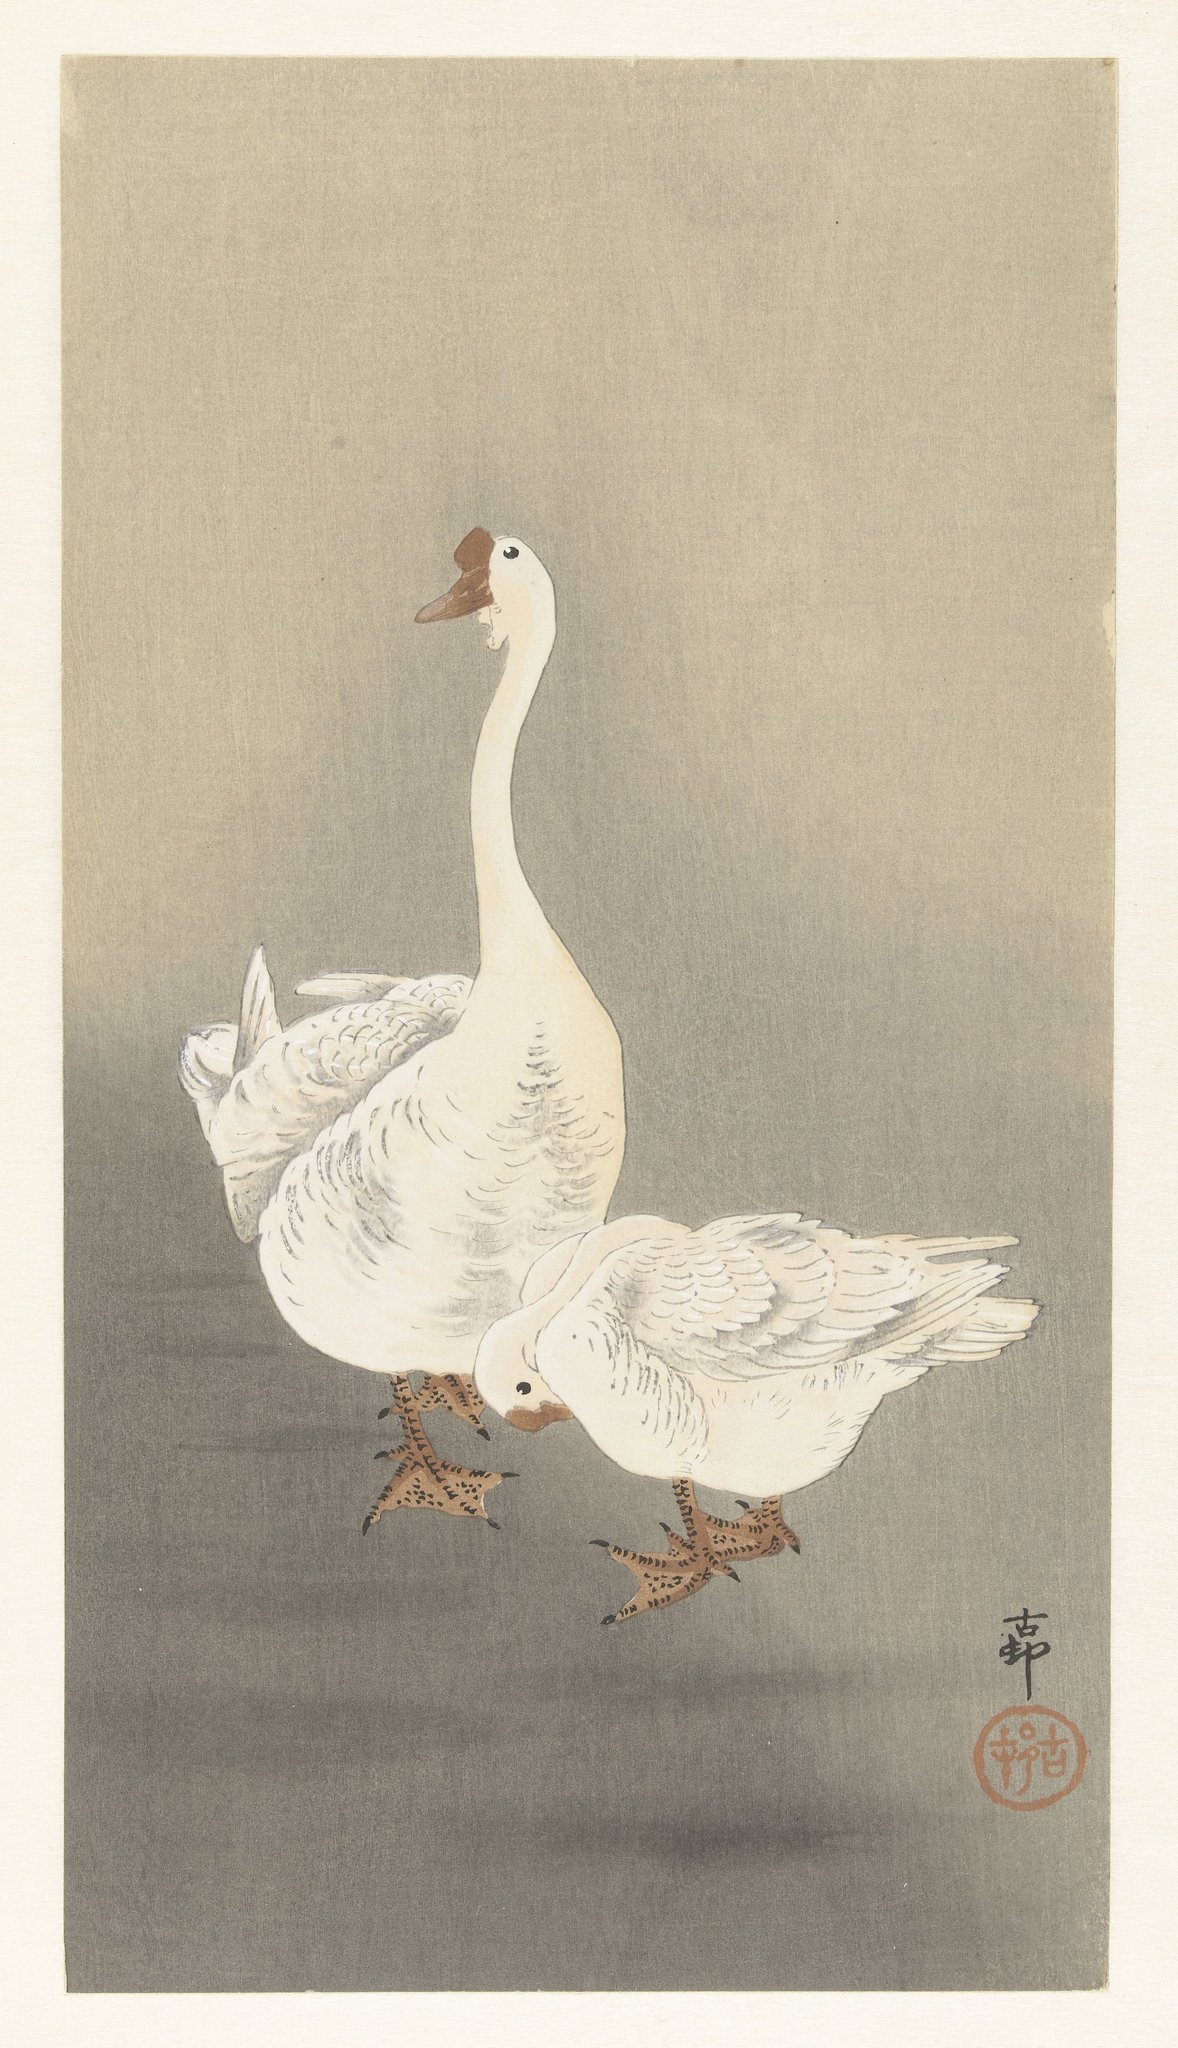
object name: print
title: Twee ganzen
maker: ohara koson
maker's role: print maker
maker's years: 1877-1945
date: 1900-1930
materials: paper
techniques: woodcut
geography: tokyo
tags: water-birds: goose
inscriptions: collector's mark: Lugt 2228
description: Twee ganzen, waarvan een de snavel onder de veren steekt